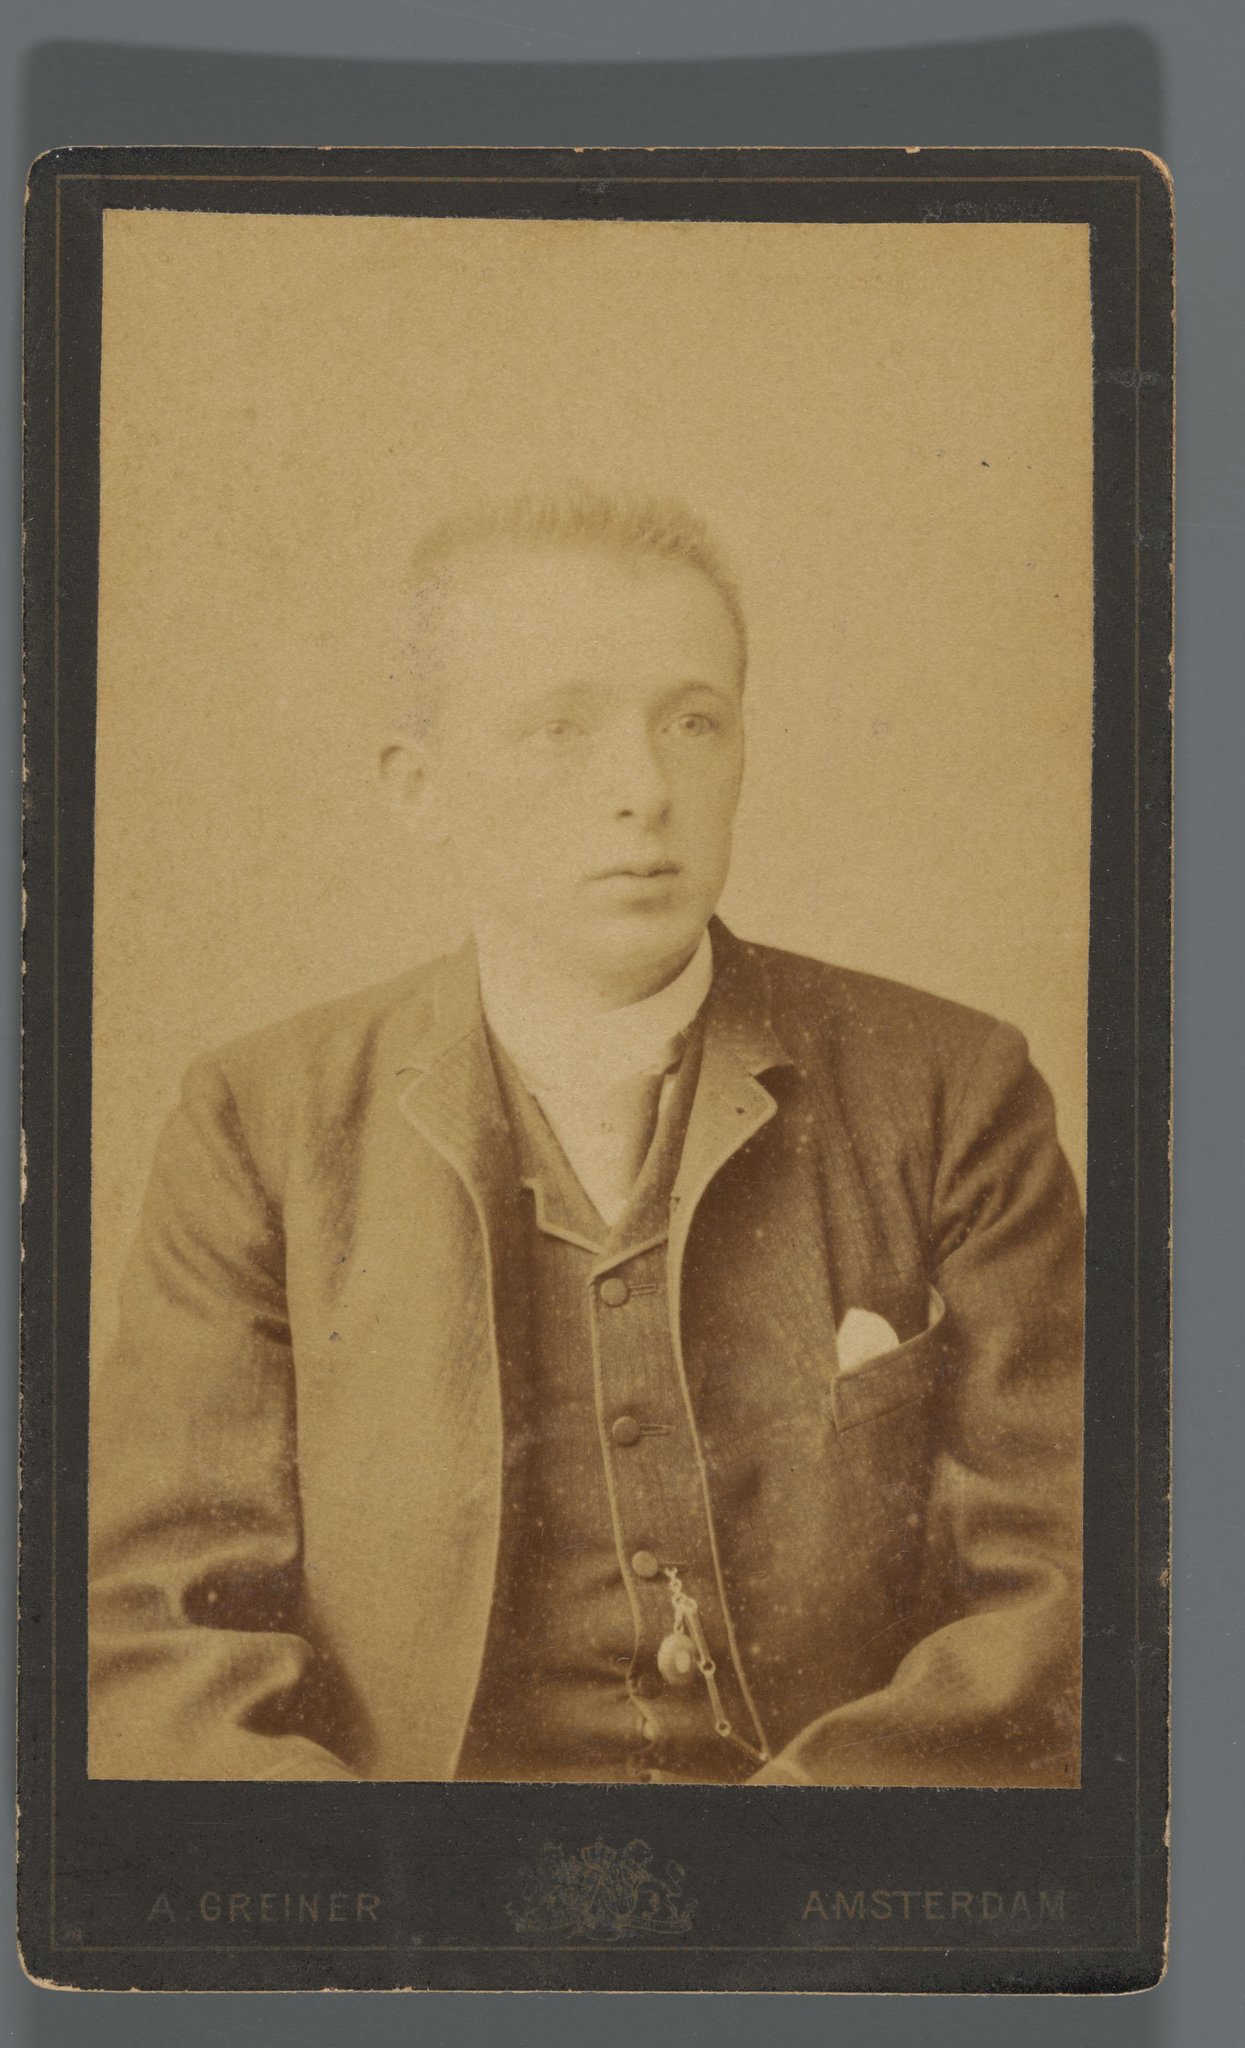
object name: carte de visite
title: Portret van A.F. Marmelstein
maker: albert greiner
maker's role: fotograaf, fotostudio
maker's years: 1833-1890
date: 1870-1900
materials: cardboard, photographic support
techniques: albumen print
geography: amsterdam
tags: adult man, historical persons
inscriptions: inscription: ‘Pa’, retailer's mark: ‘Albert Greiner/ Kon. Ned. Hog-Photograaf/ Amsterdam/ Nieuwendijk 89. (...)’